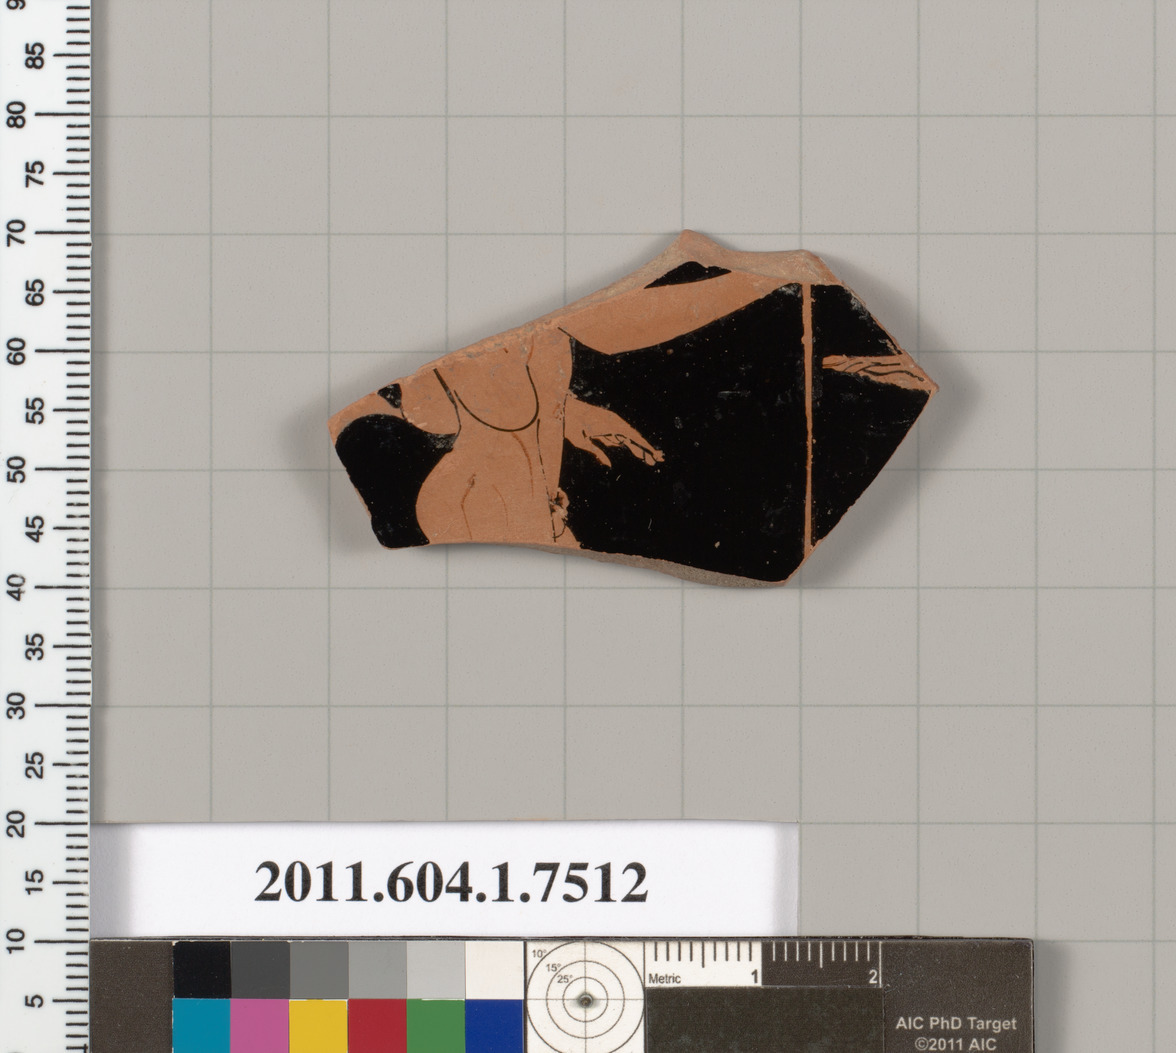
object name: kylix fragment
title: Terracotta fragment of a kylix (drinking cup)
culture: greek, attic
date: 460-450 BCE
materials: terracotta